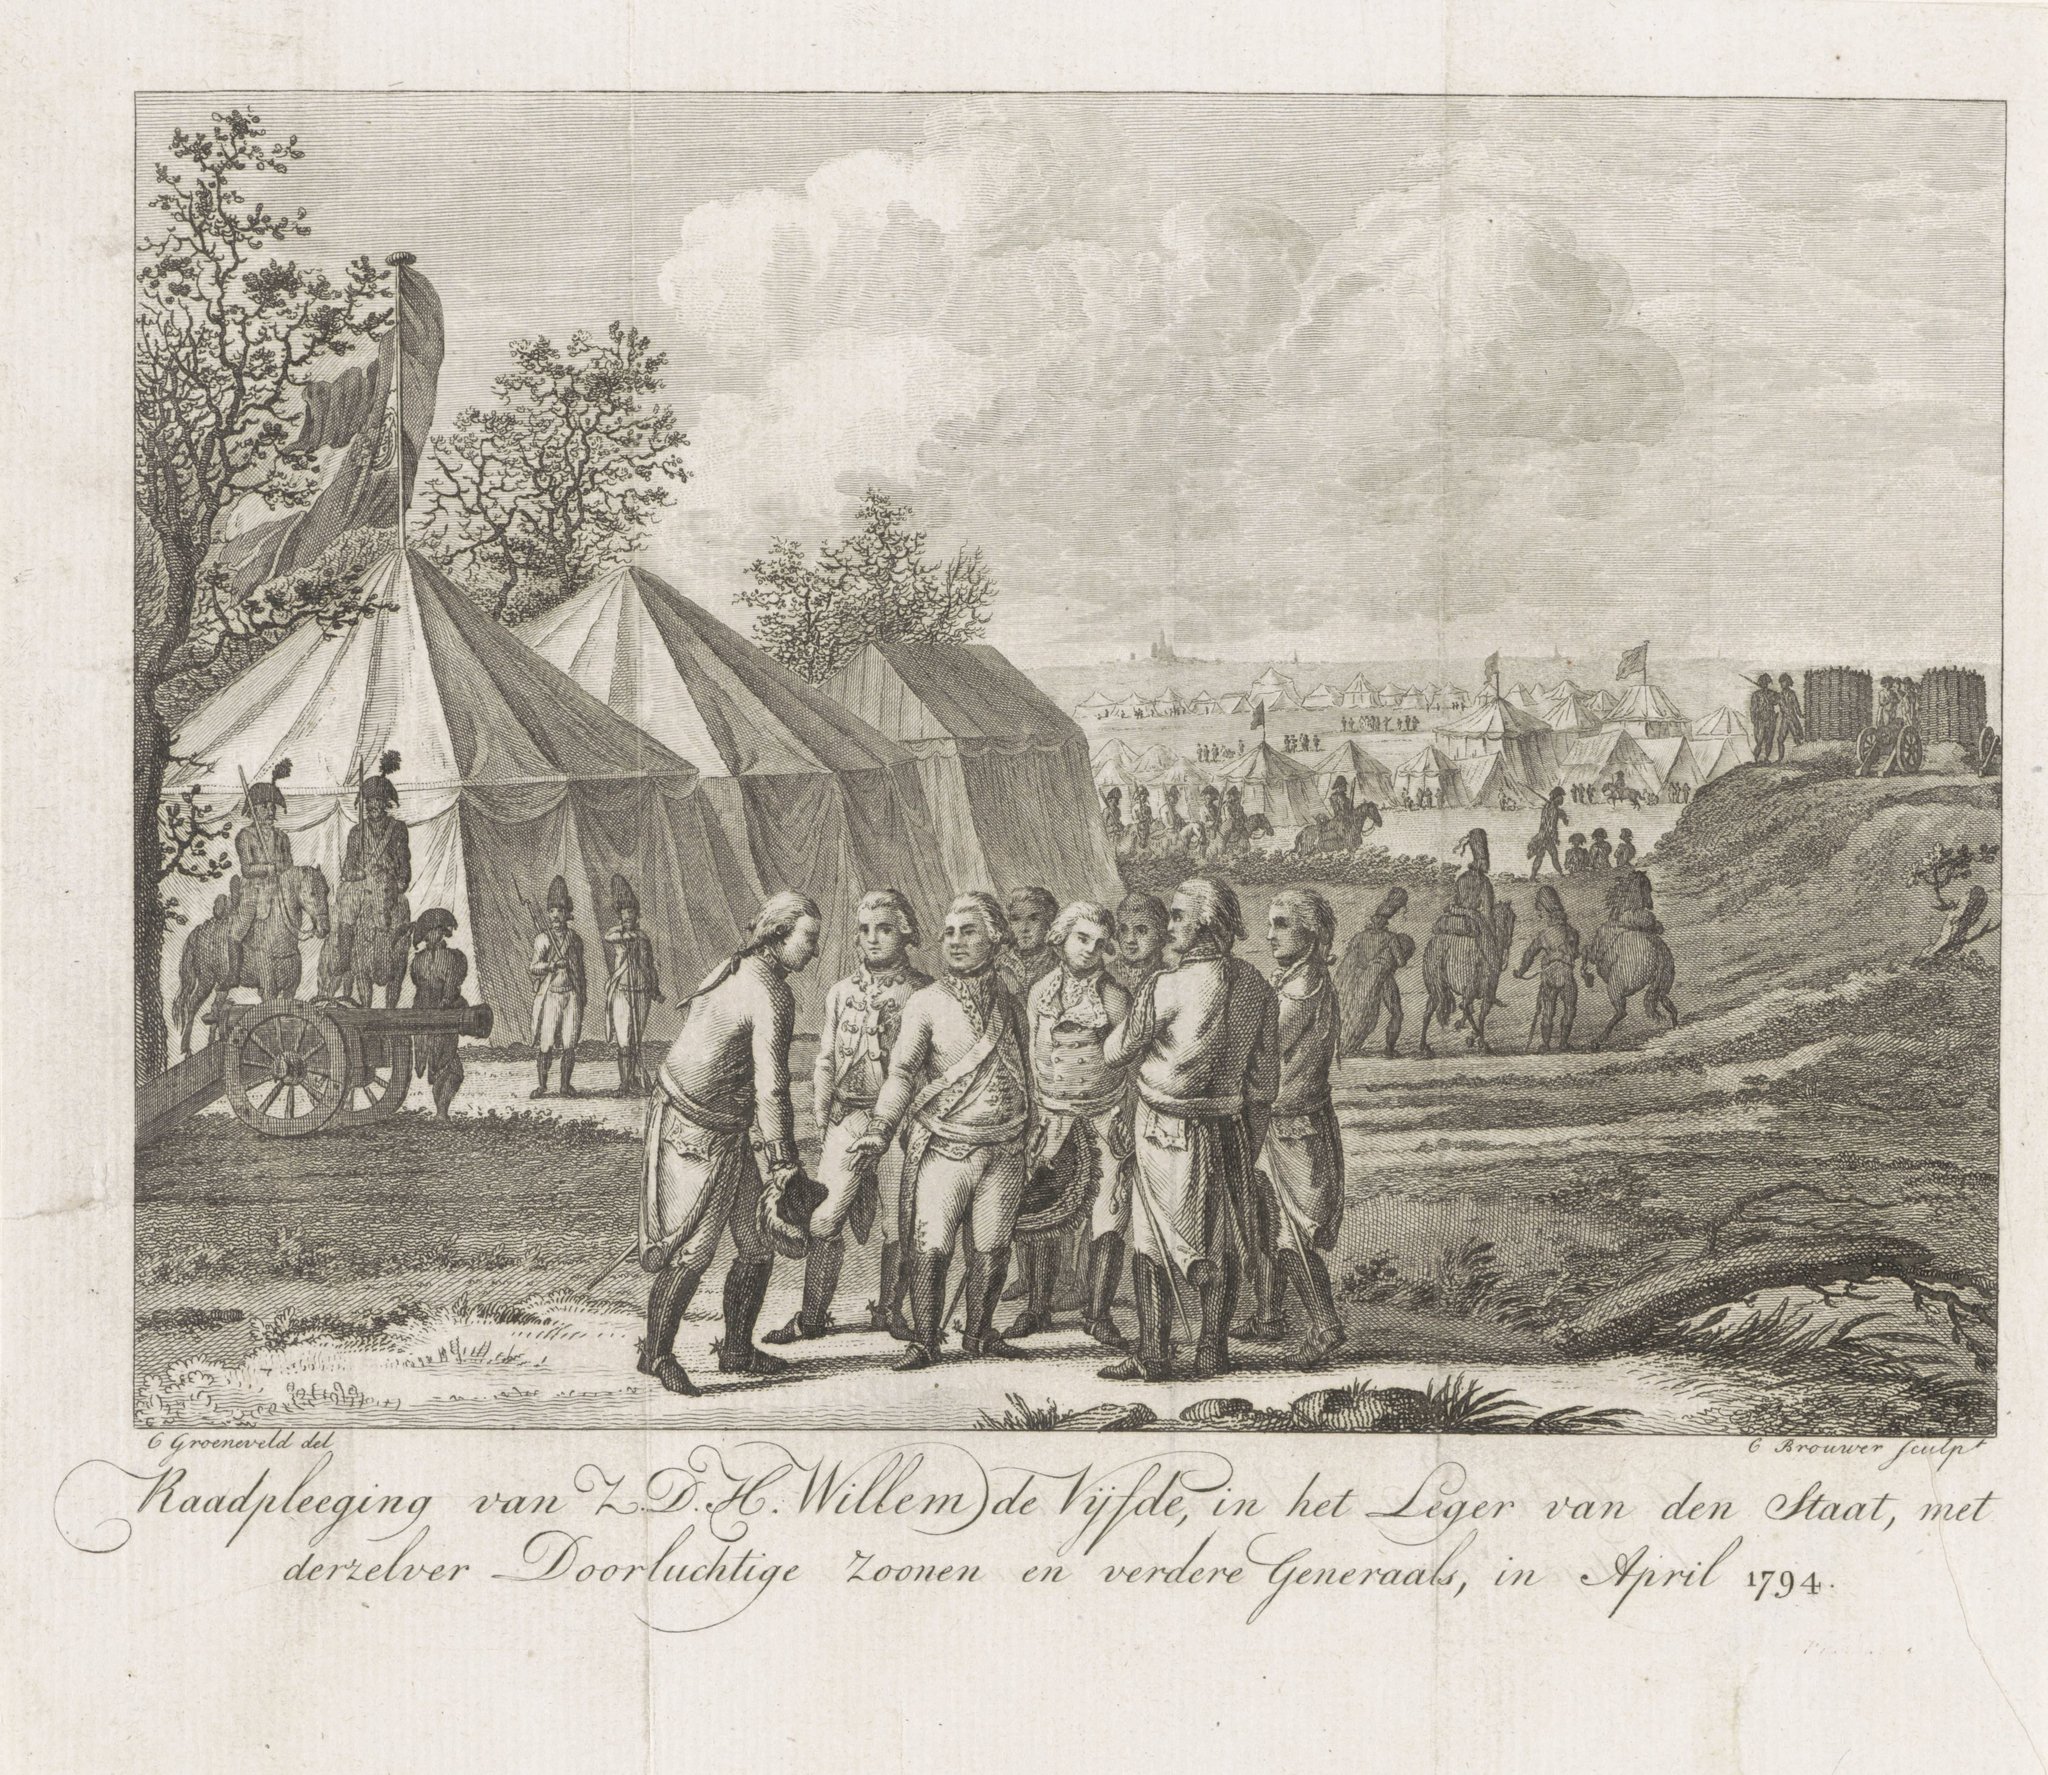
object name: history print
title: Raadpleeging van Z.D.H. Willem de Vijfde, in het Leger van den Staat, met derzelver Doorluchtige zoonen en verdere Generaals, in April 1794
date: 1802-1803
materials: paper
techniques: engraving, etching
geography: northern netherlands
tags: william v (prince of orange), the hague, berlin, william i of the netherlands, willem george frederik (prins van oranje-nassau), (military) camp with tents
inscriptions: collector's mark: Lugt 2228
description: Stadhouder Willem V met zijn zonen Willem George Frederik en Willem I Frederik in overleg met de generaals, tussen de tenten van het legerkamp in de Zuidelijke Nederlanden, april 1794.